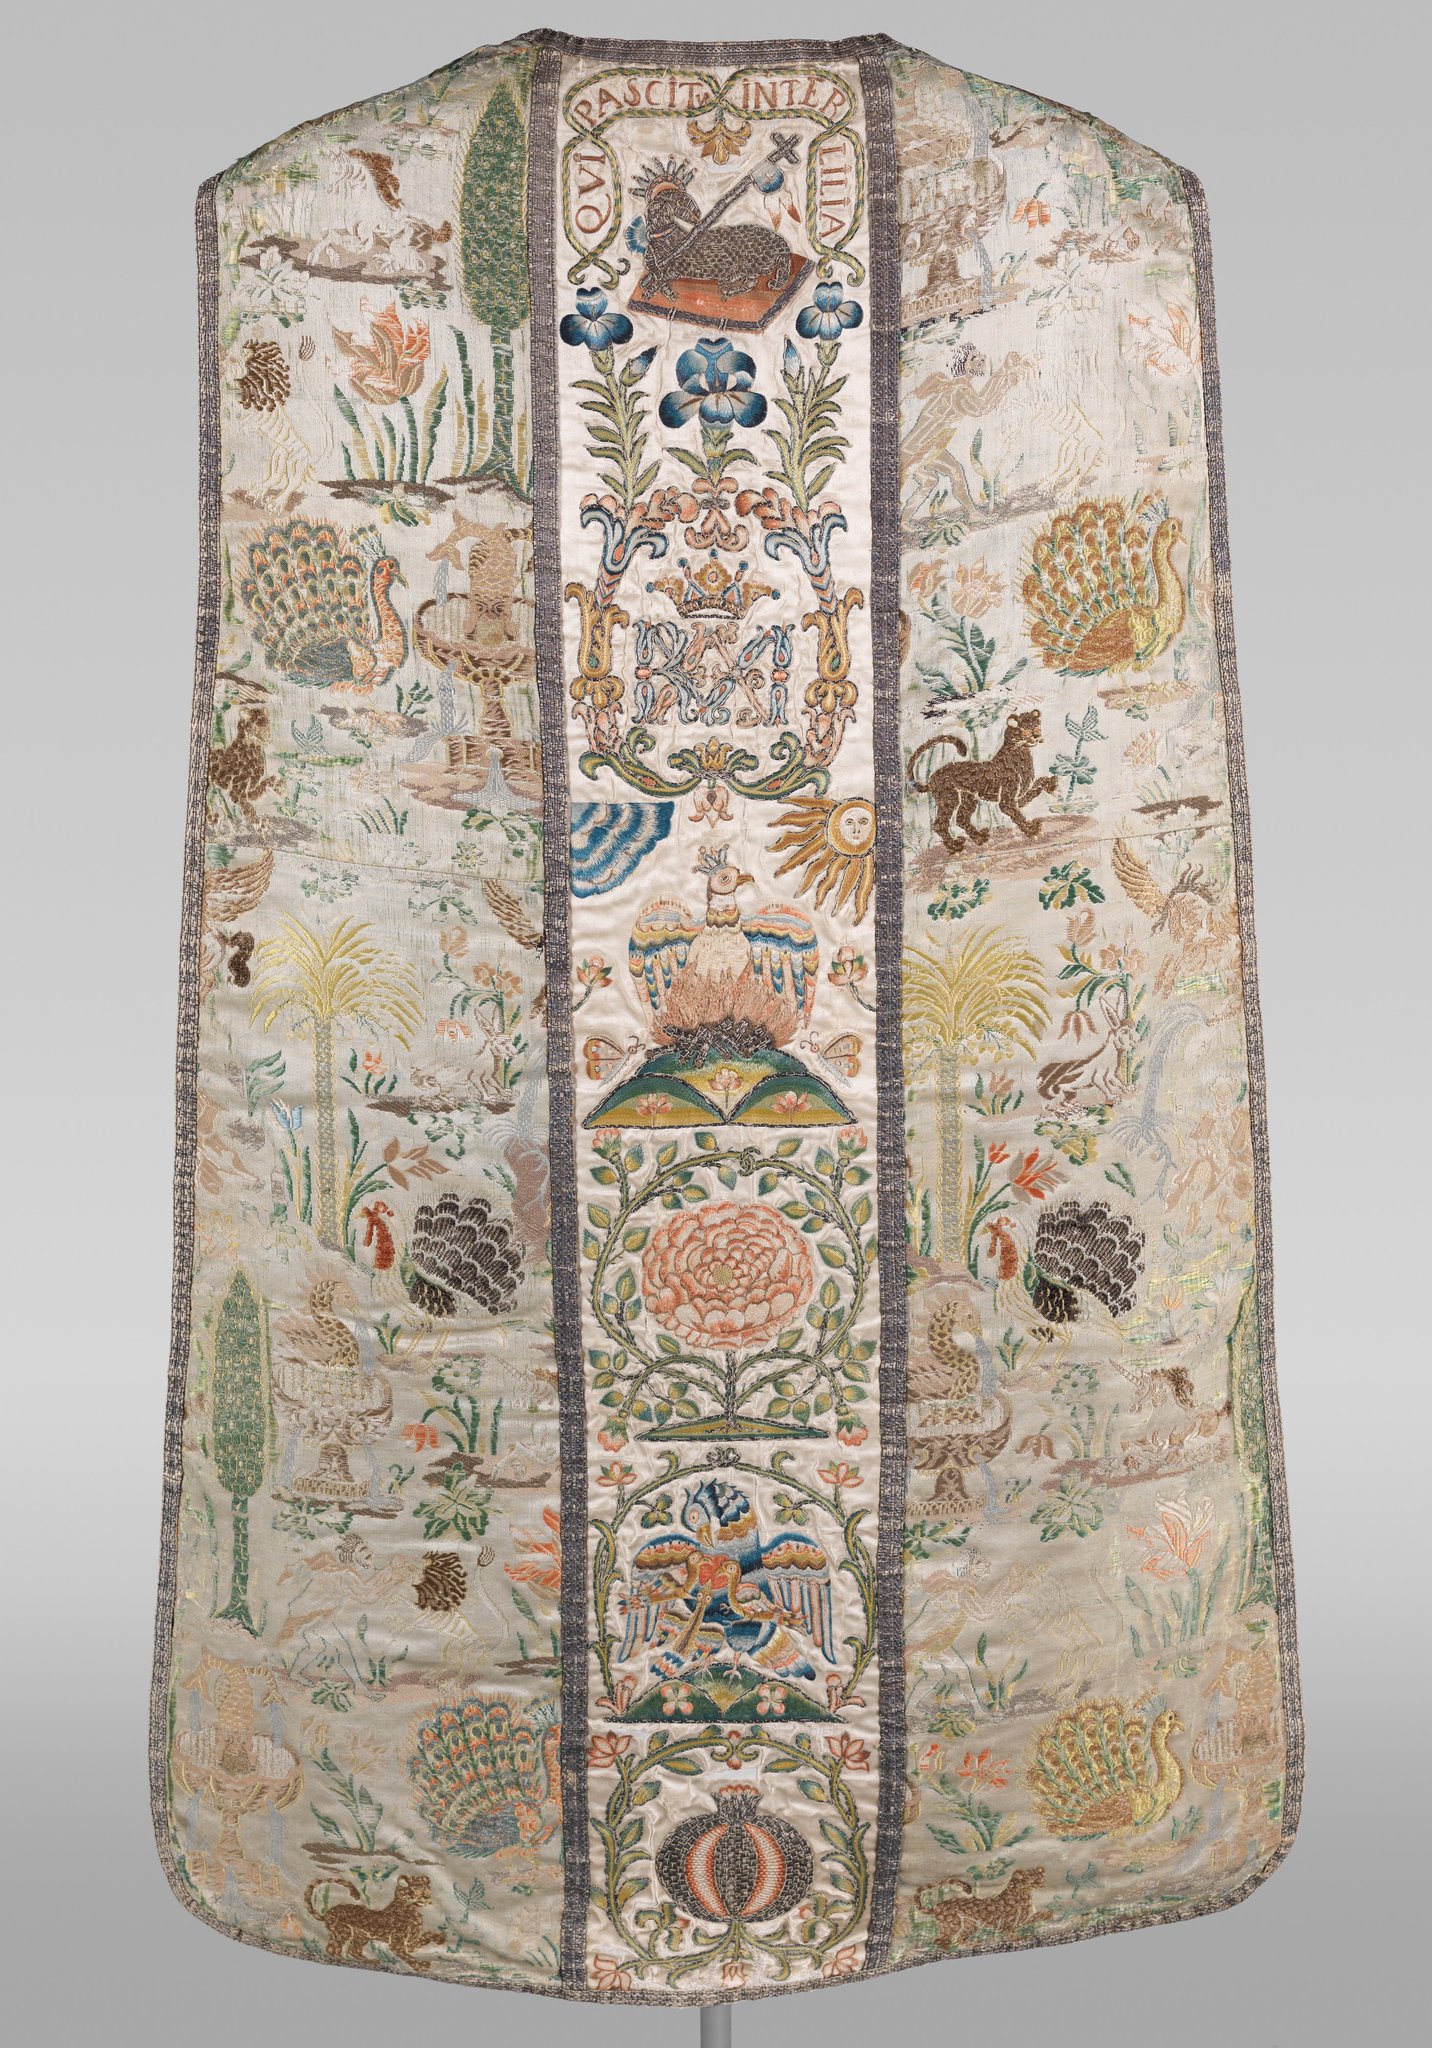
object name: chasuble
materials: metal thread, silk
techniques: brocade, embroidery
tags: birds,fountains,unicorns,peacocks,turkeys,leopards,lions